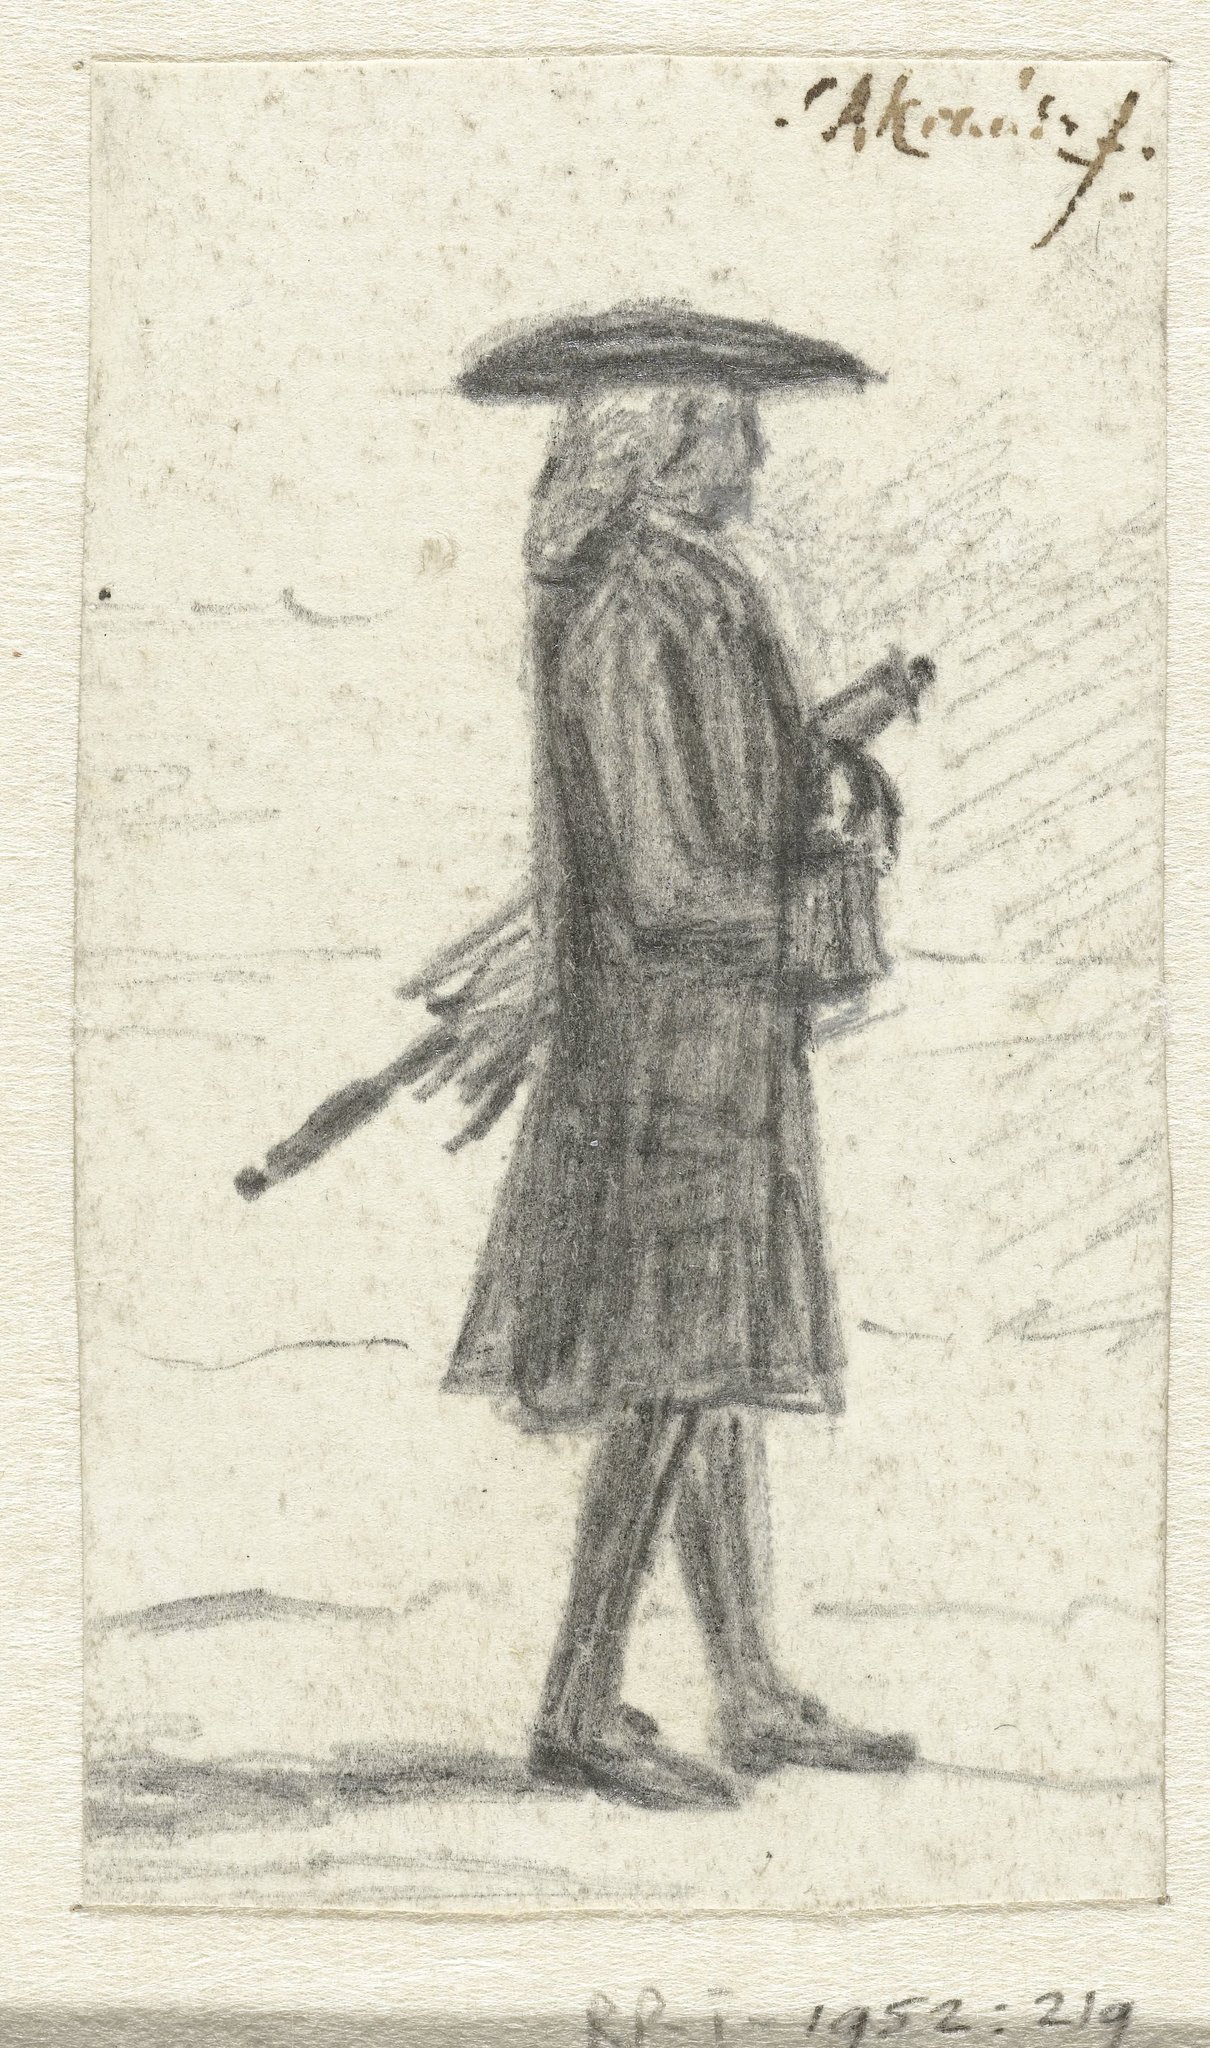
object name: drawing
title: Lopende man, naar rechts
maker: simon andreas krausz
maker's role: draughtsman, print maker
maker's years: 1760-1825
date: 1770-1825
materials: paper, pencil